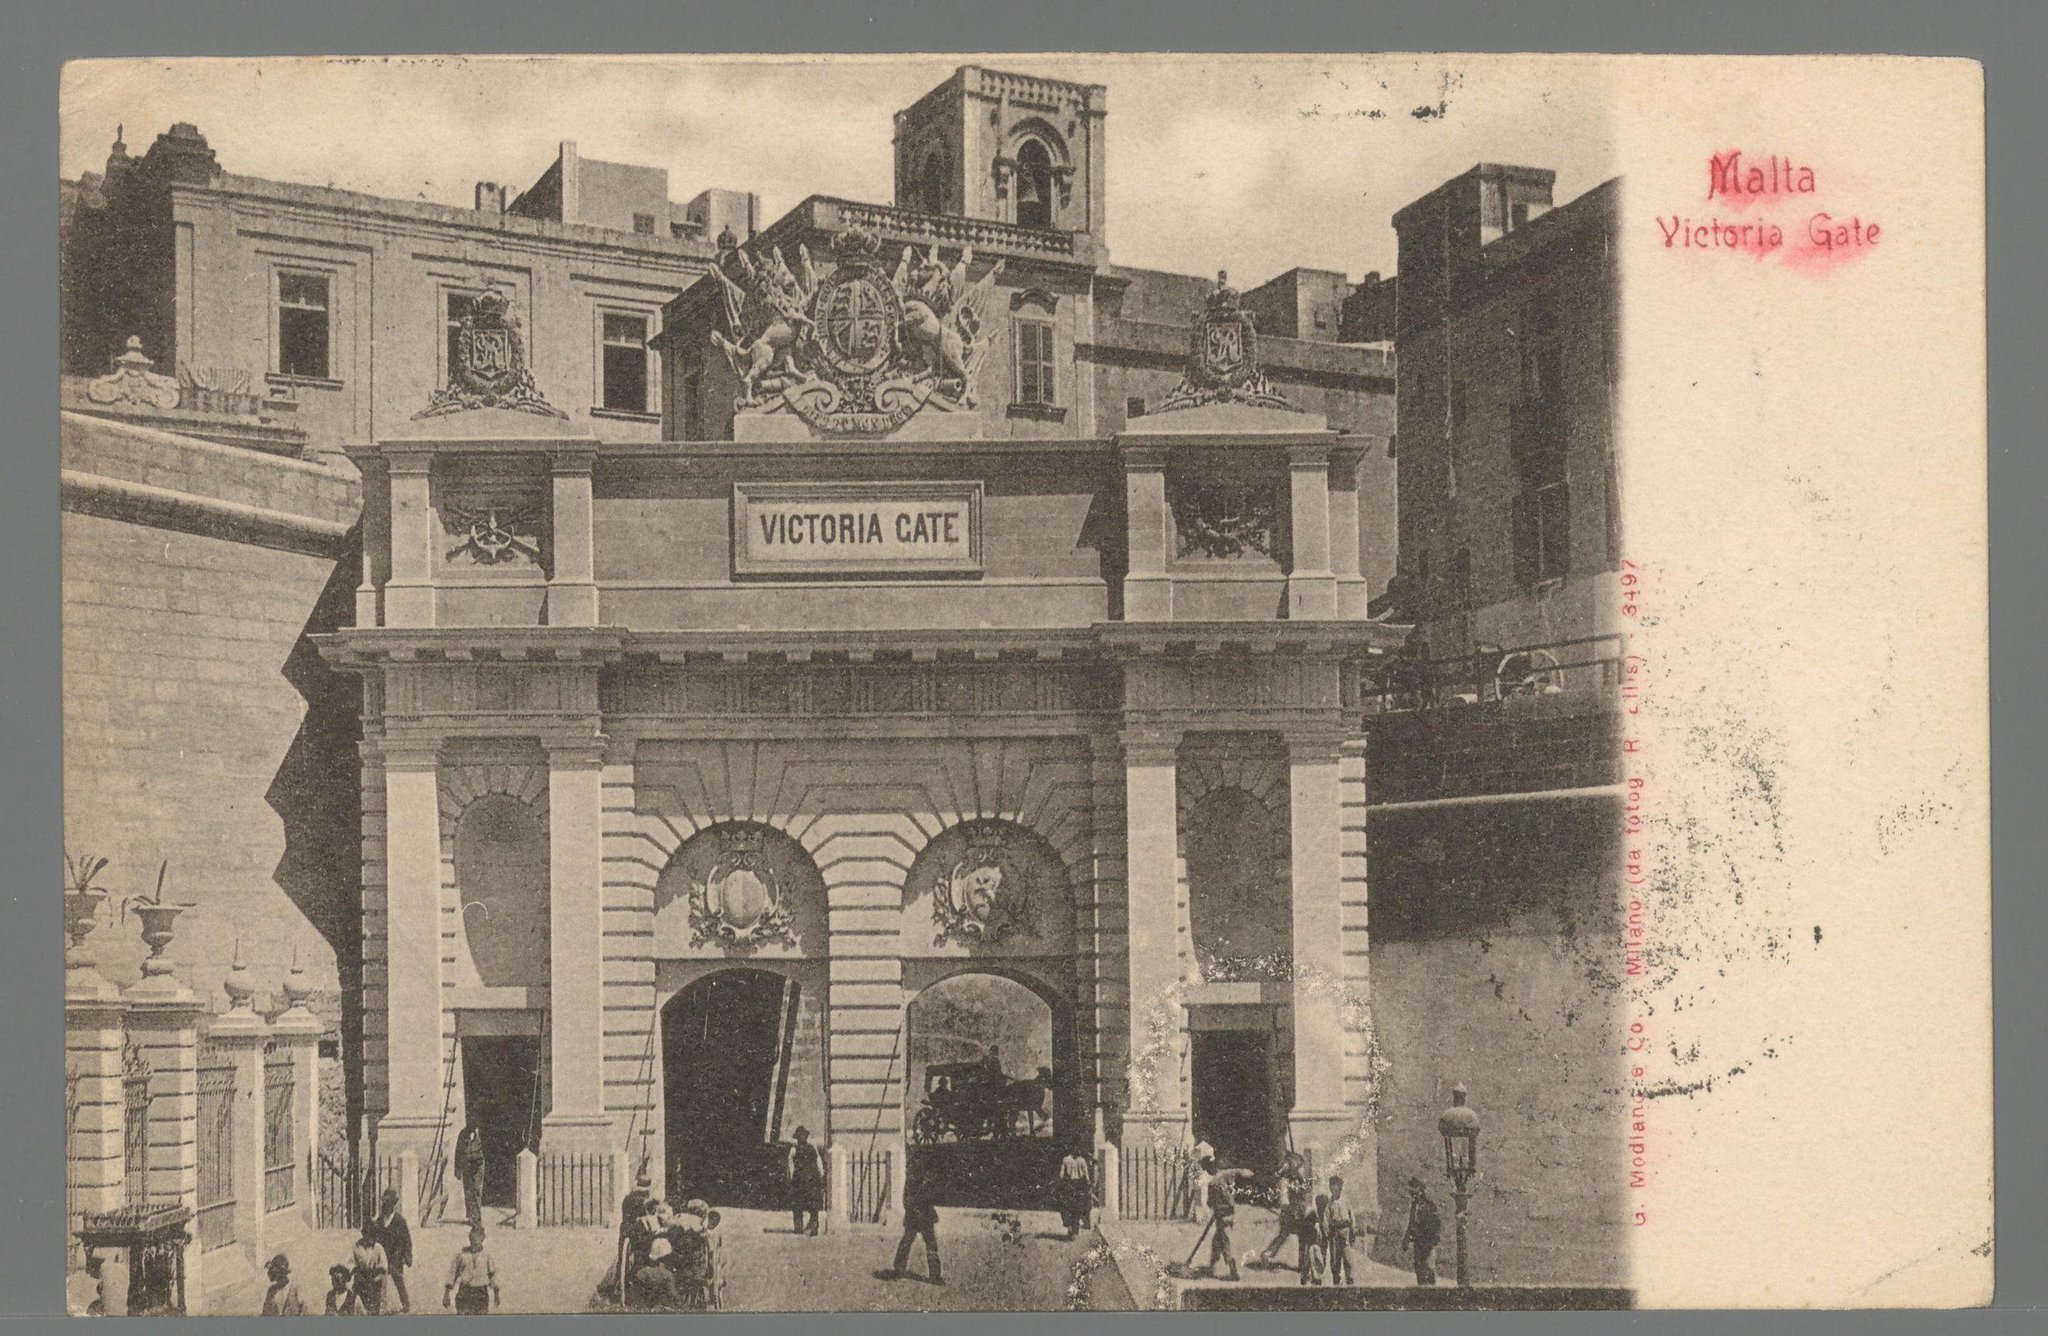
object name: ansichtkaart, prentbriefkaart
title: Malta. Victoria Gate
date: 1890-1903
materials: cardboard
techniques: photograph, writing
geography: milan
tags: city-gate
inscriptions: poststempel, verso, gestempeld